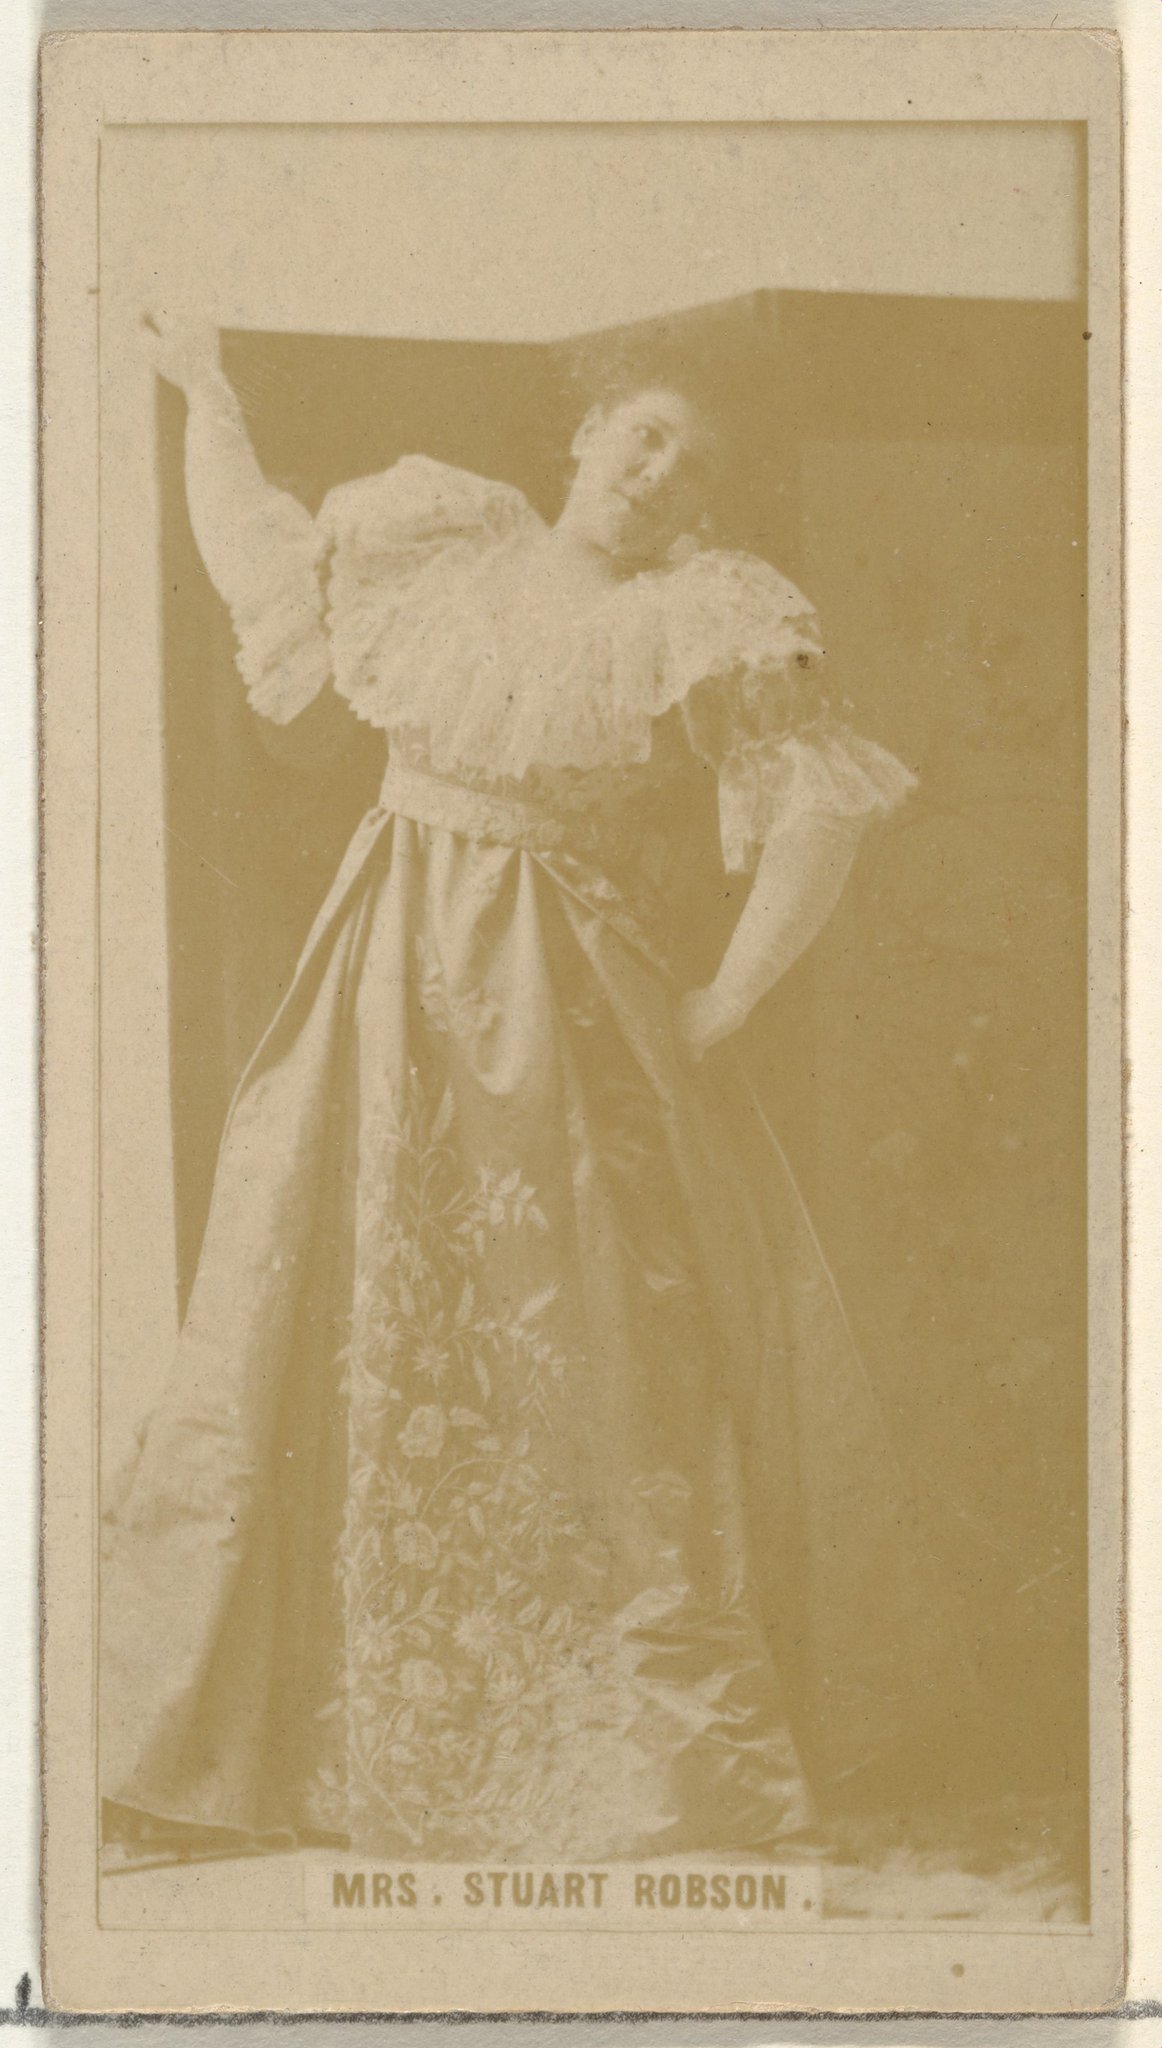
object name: photograph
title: Mrs. Stuart Robson, from the Actors and Actresses series (N145-8) issued by Duke Sons & Co. to promote Duke Cigarettes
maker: w. duke, sons & co.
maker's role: publisher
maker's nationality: american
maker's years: 1870-1920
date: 1891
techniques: albumen silver print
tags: portraits,women,actresses